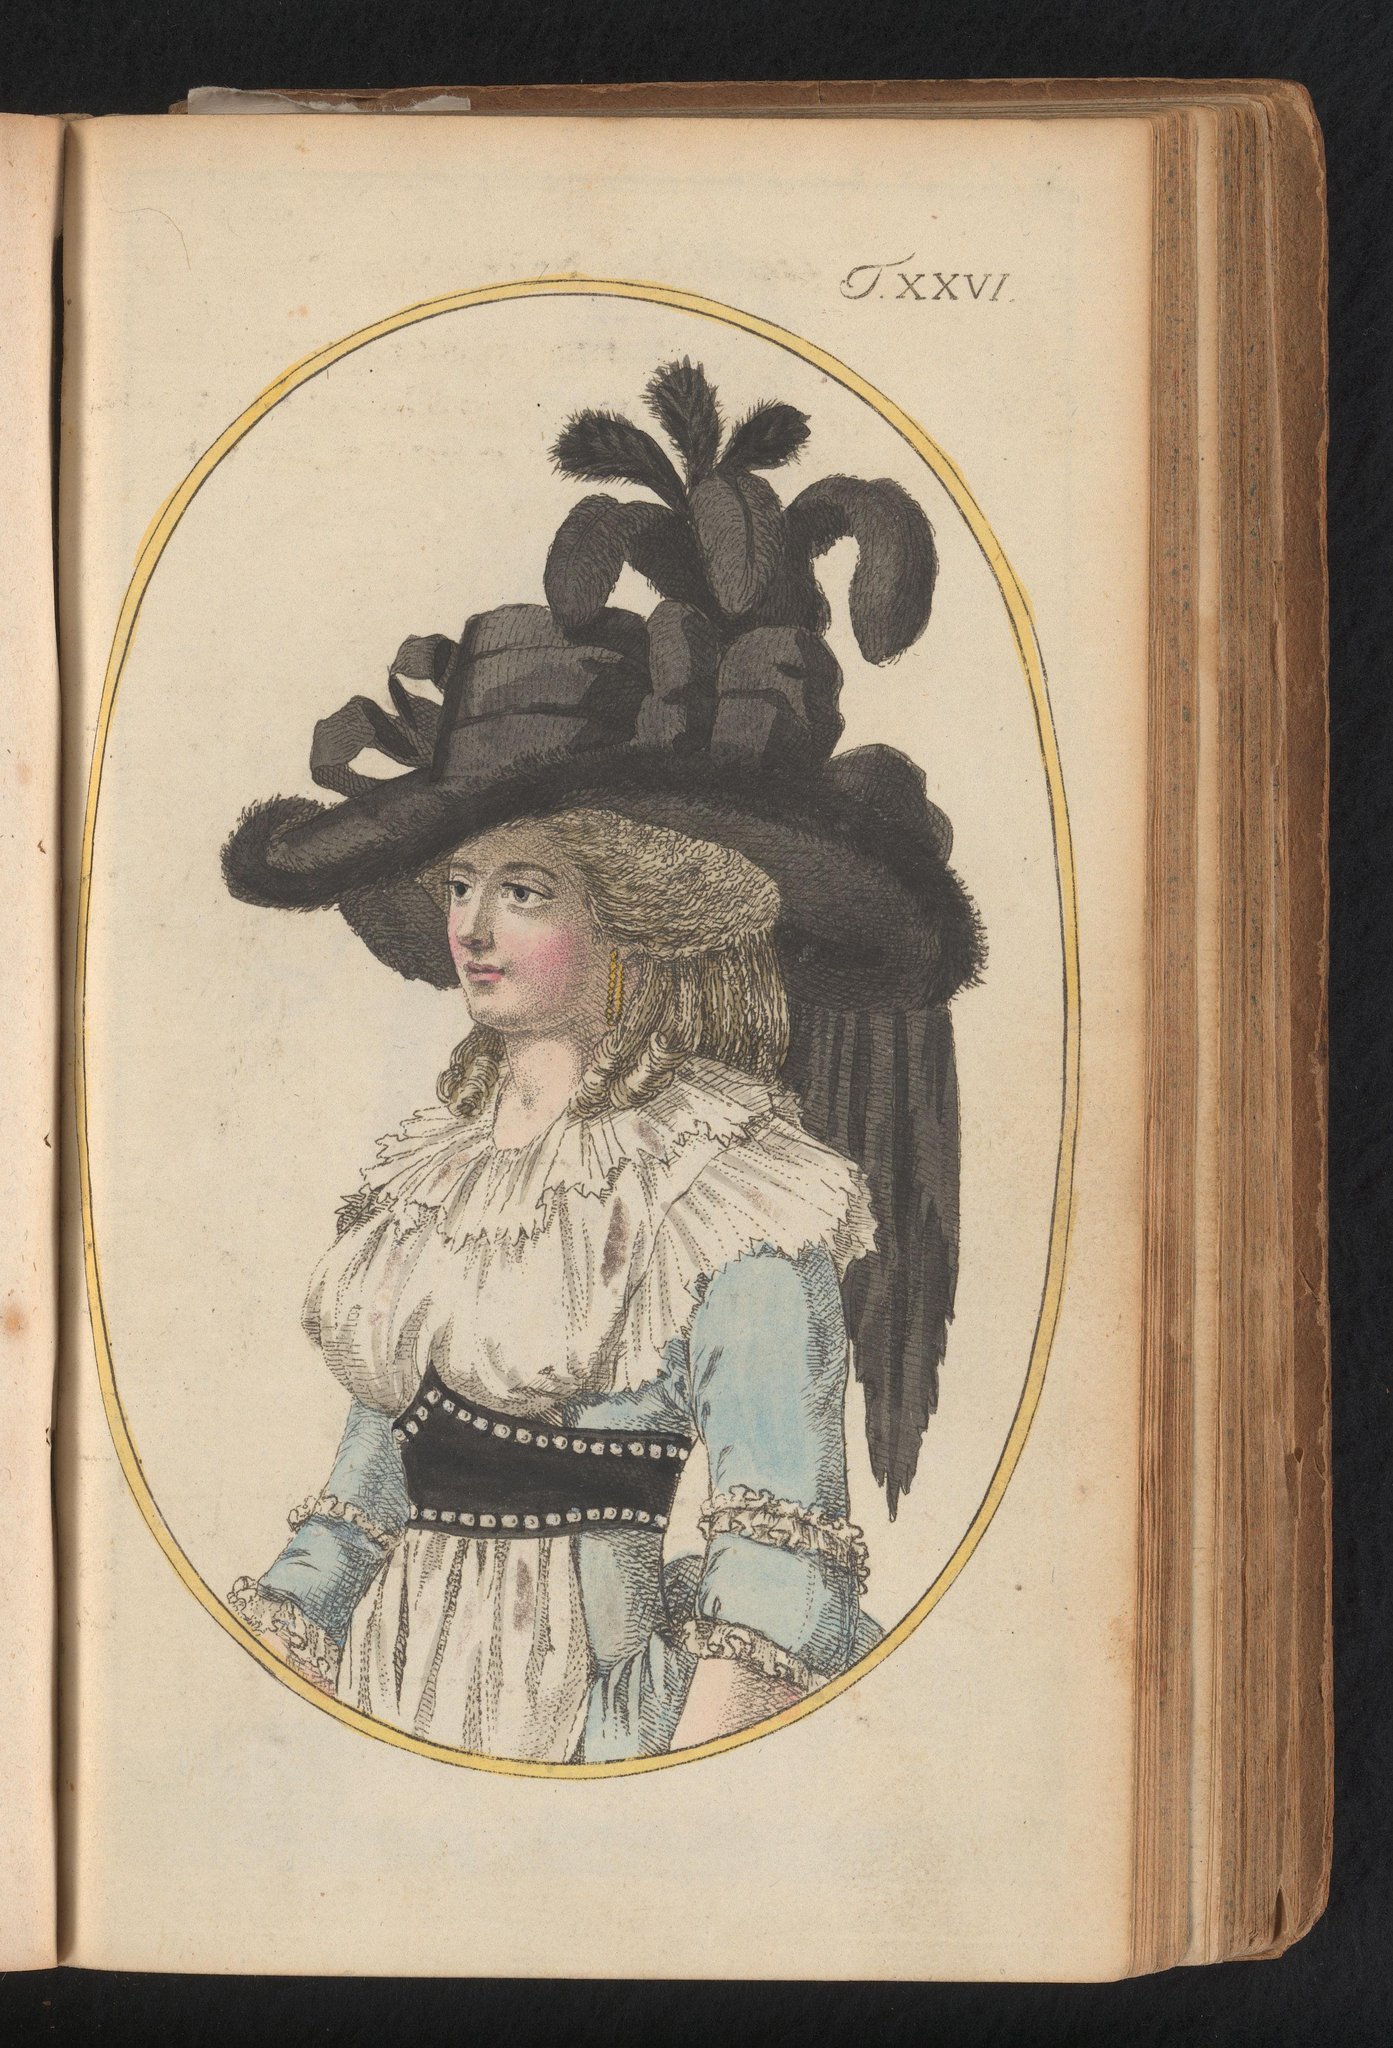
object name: fashion print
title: Journal des Luxus und der Moden 1786, Band I, T. 26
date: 1786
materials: paper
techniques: etching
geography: weimar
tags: fashion plates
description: Grote zwarte strohoed, waarvan de rand is afgezet met zwarte struisveertjes. Om de bol een driehoekige 'Soubise'van zwarte kant, die aan de achterkant in een sluier afhangt; versierd met struisveren. Fichu 'à la Ceinture de Didon', bestaand uit een halsdoek en een antieke ceintuur zoals die door de Griekse en Romeinse vrouwen onder de borsten werd gedragen. Engelse japon van blauwe tafzijde. Prent uit het modetijdschrift Journal des Luxus und der Moden, uitgegeven door Friedrich Justin Bertuch en Georg Melchior Kraus, Weimar, 1786-1826.